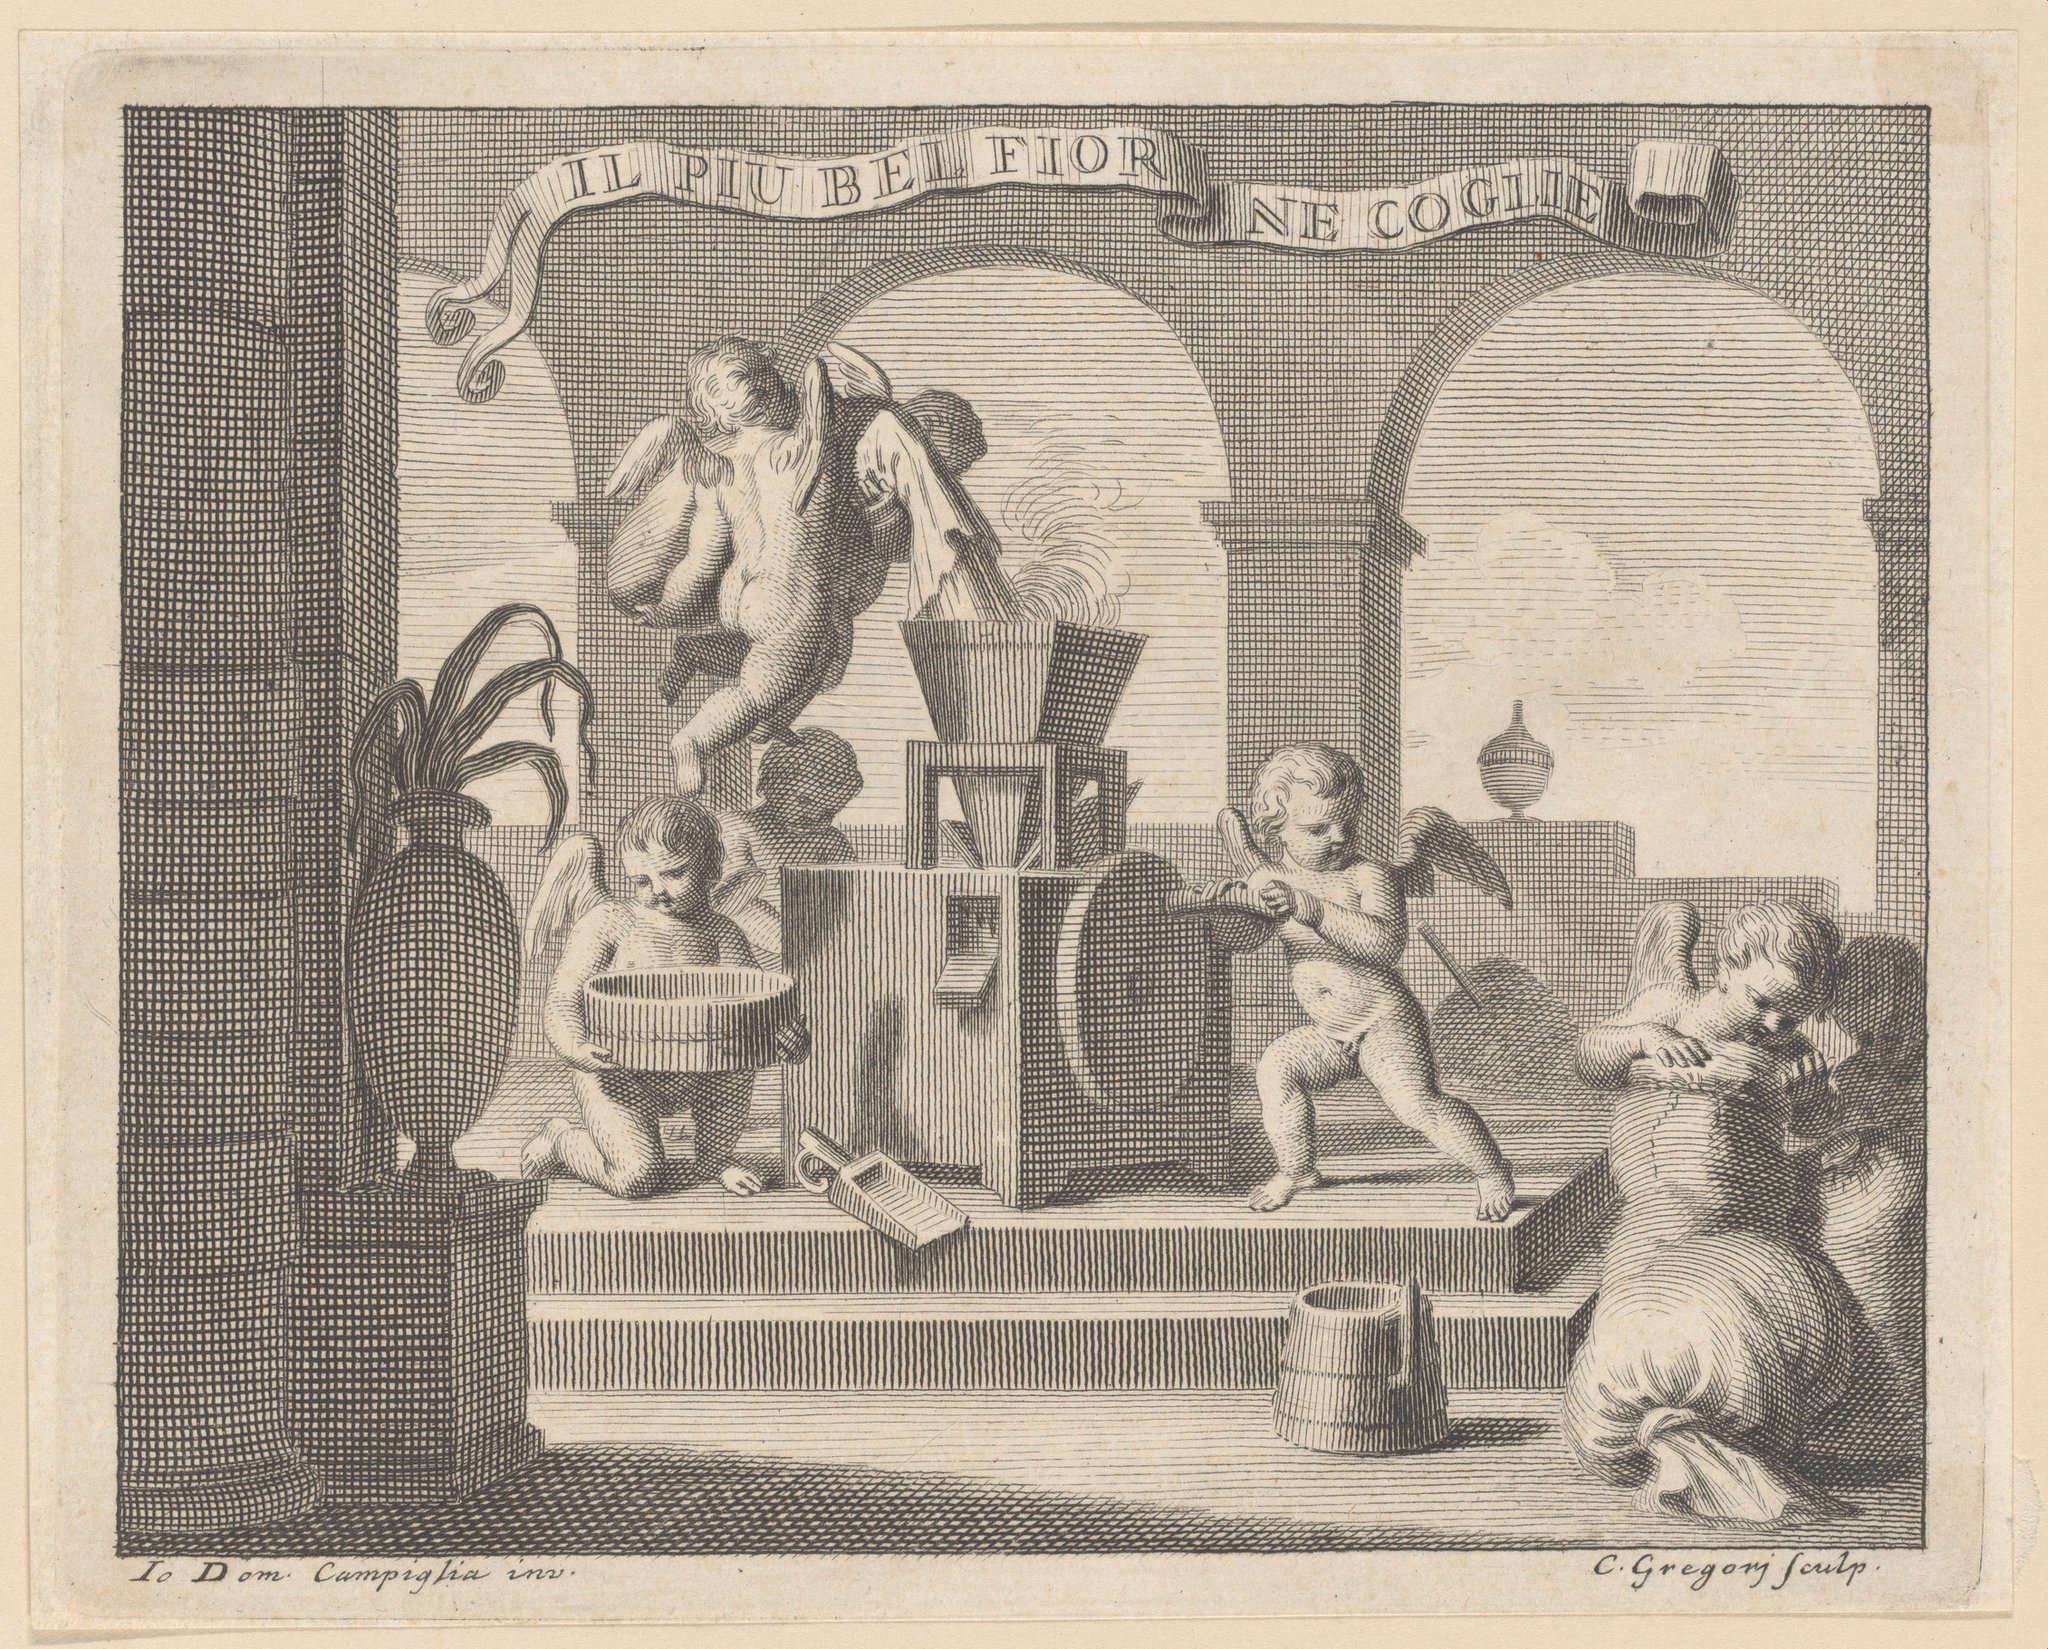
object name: print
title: She gathers the fairest flower (Il più bel fior ne coglie), a group of six putti working together in an arched workshop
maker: carlo gregori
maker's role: artist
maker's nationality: italian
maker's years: 1719-1759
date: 1740-1759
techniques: etching